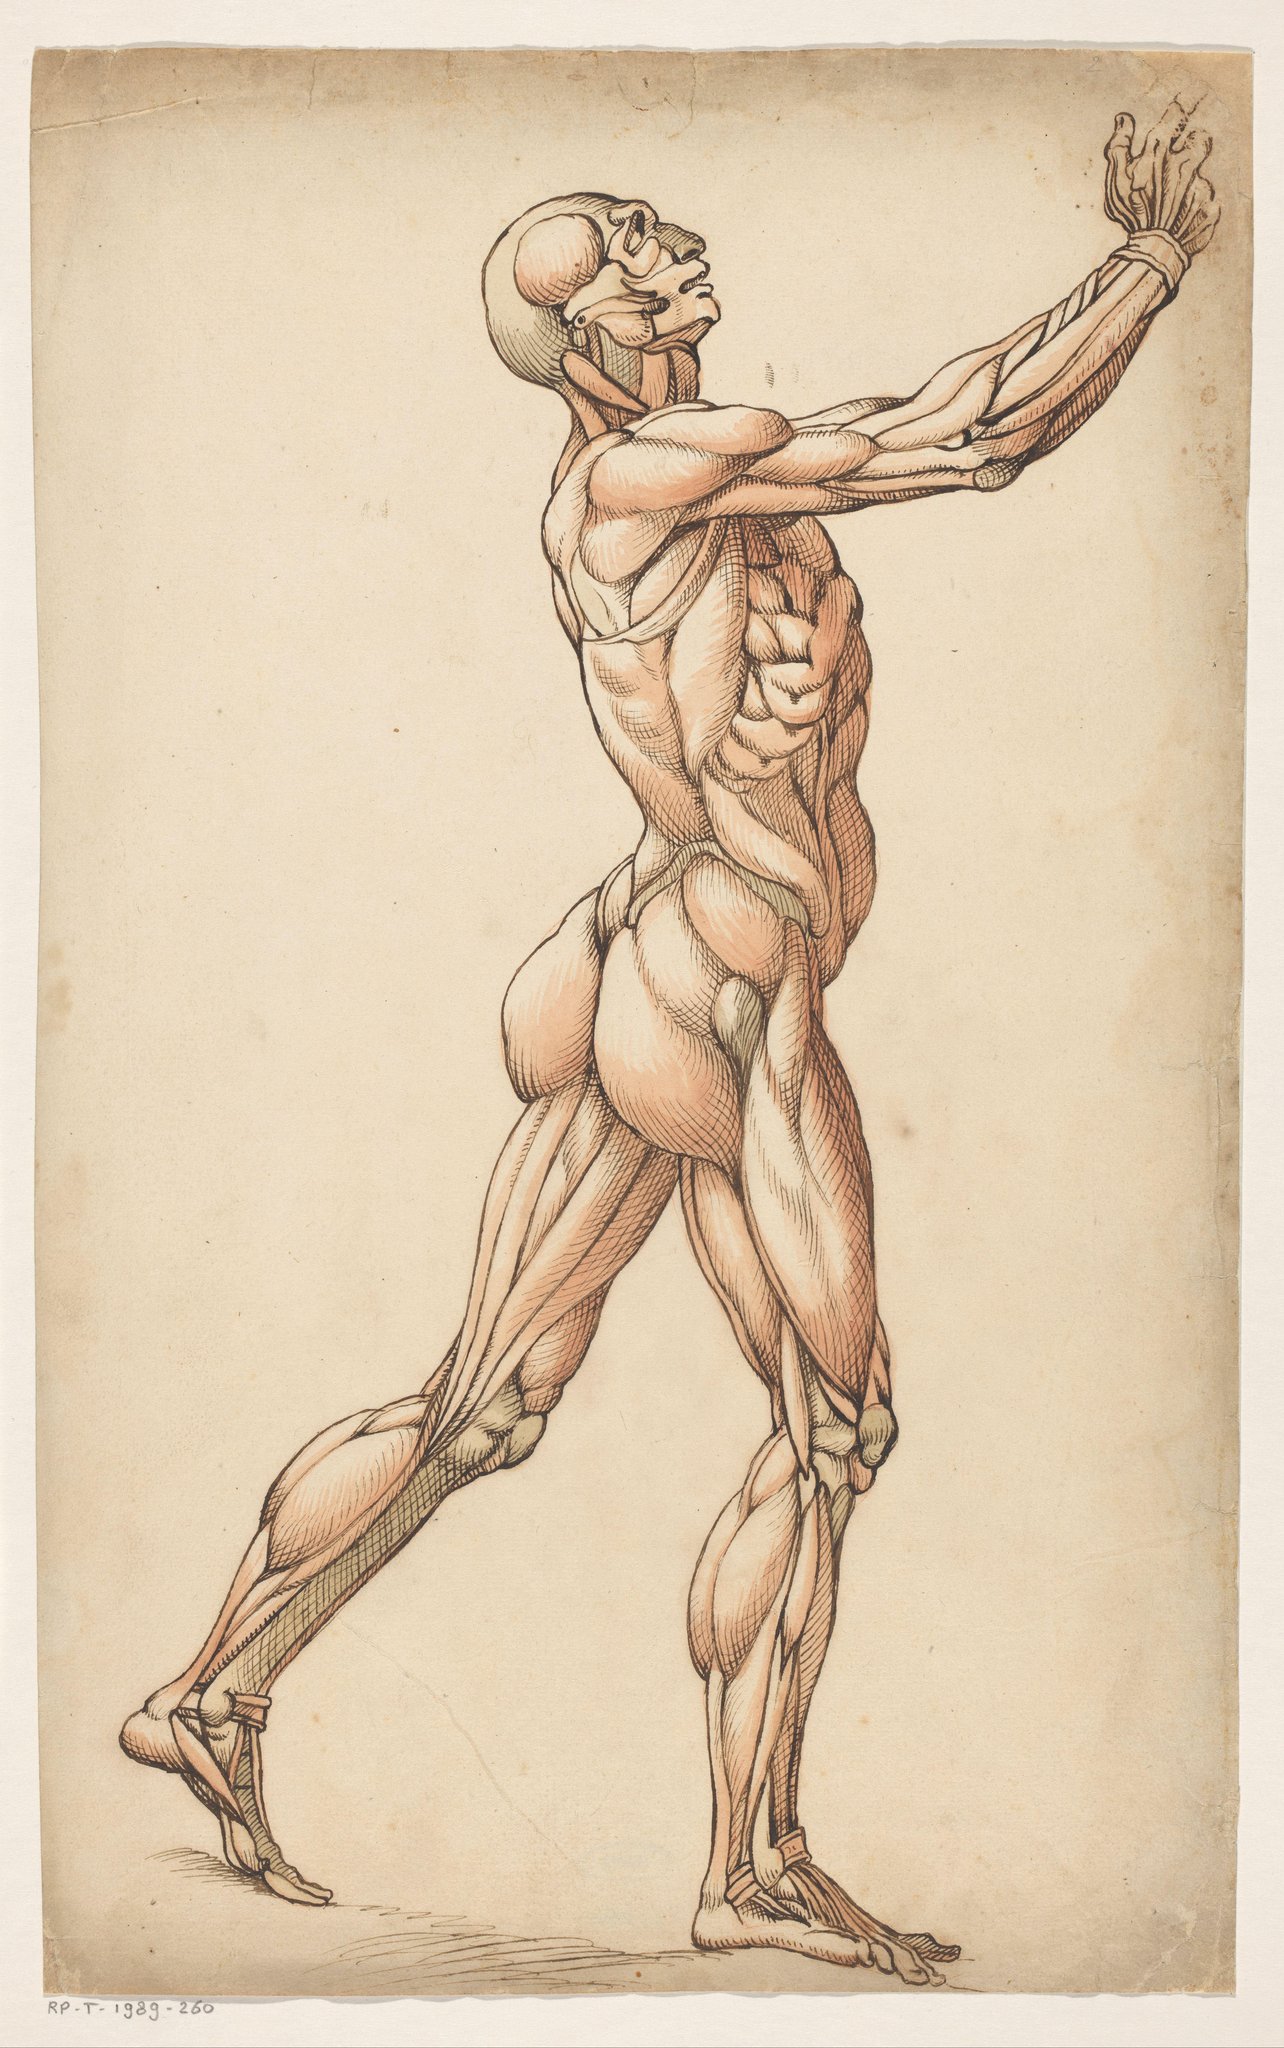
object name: drawing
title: Spieren van het menselijk lichaam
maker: Anonymous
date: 1600-1649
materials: ink, paper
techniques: brush, pen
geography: low countries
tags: muscles, anatomical model of the muscles, muscle-man, 'écorché'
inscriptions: collector's mark: Lugt 2228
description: De tekening komt sterk overeen met een prent in: Gracht, Jacob van der. Anatomie der wtterlicke deelen van het menschelick lichaem (...). Den Haag: Jacob van der Gracht, 1634. De tekening is echter gespiegeld en zou mogelijk als voorbeeld voor de prent kunnen hebben gediend. De houding waarin het lichaam is afgebeeld gaat terug tot: Vesalius, Andreas. De humani corporis fabrica libri septem (...). Bazel: Johannes Oporinus, 1543. Tekening zit in een omslag met meerdere anatomische tekeningen, genummerd RP-T-1989-256 en RP-T-1989-258 t/m RP-T-1989-289.